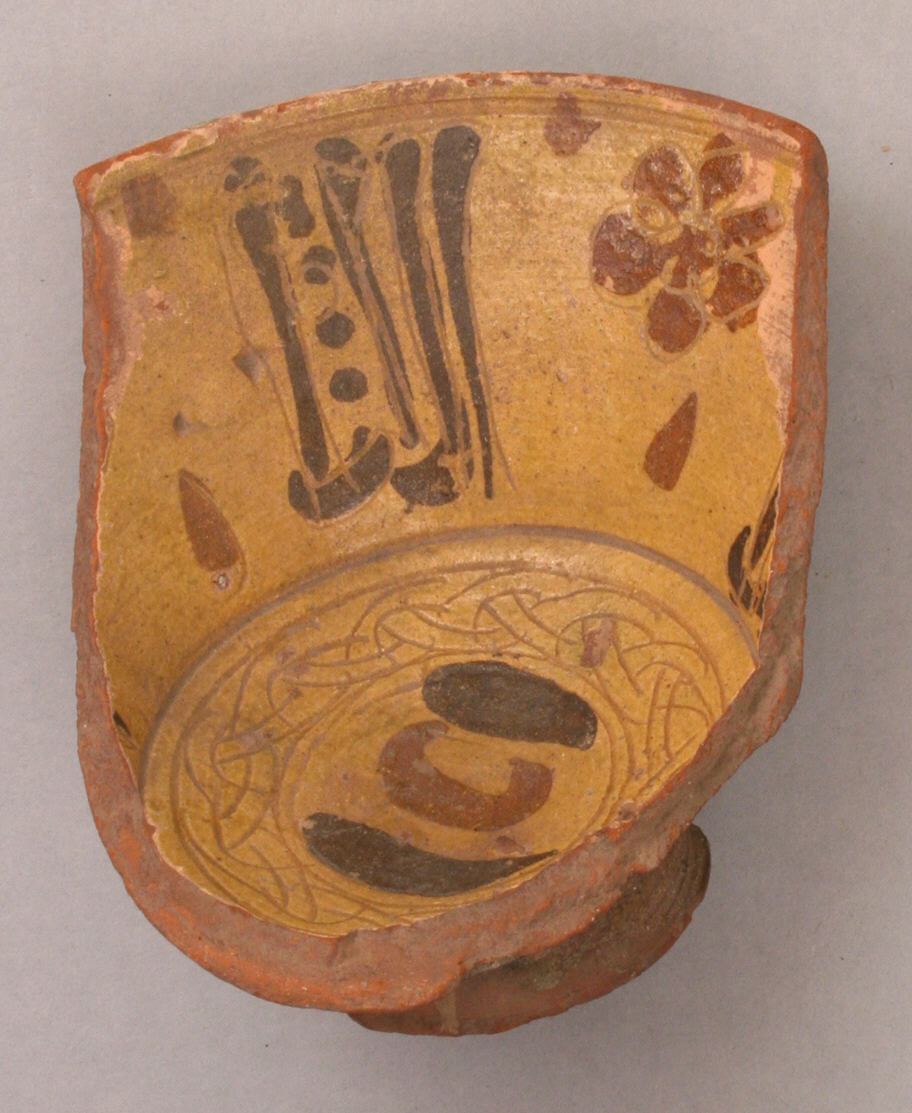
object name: fragment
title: Fragment of a Bowl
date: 1301-1500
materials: earthenware, glaze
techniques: coloring, incising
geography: egypt